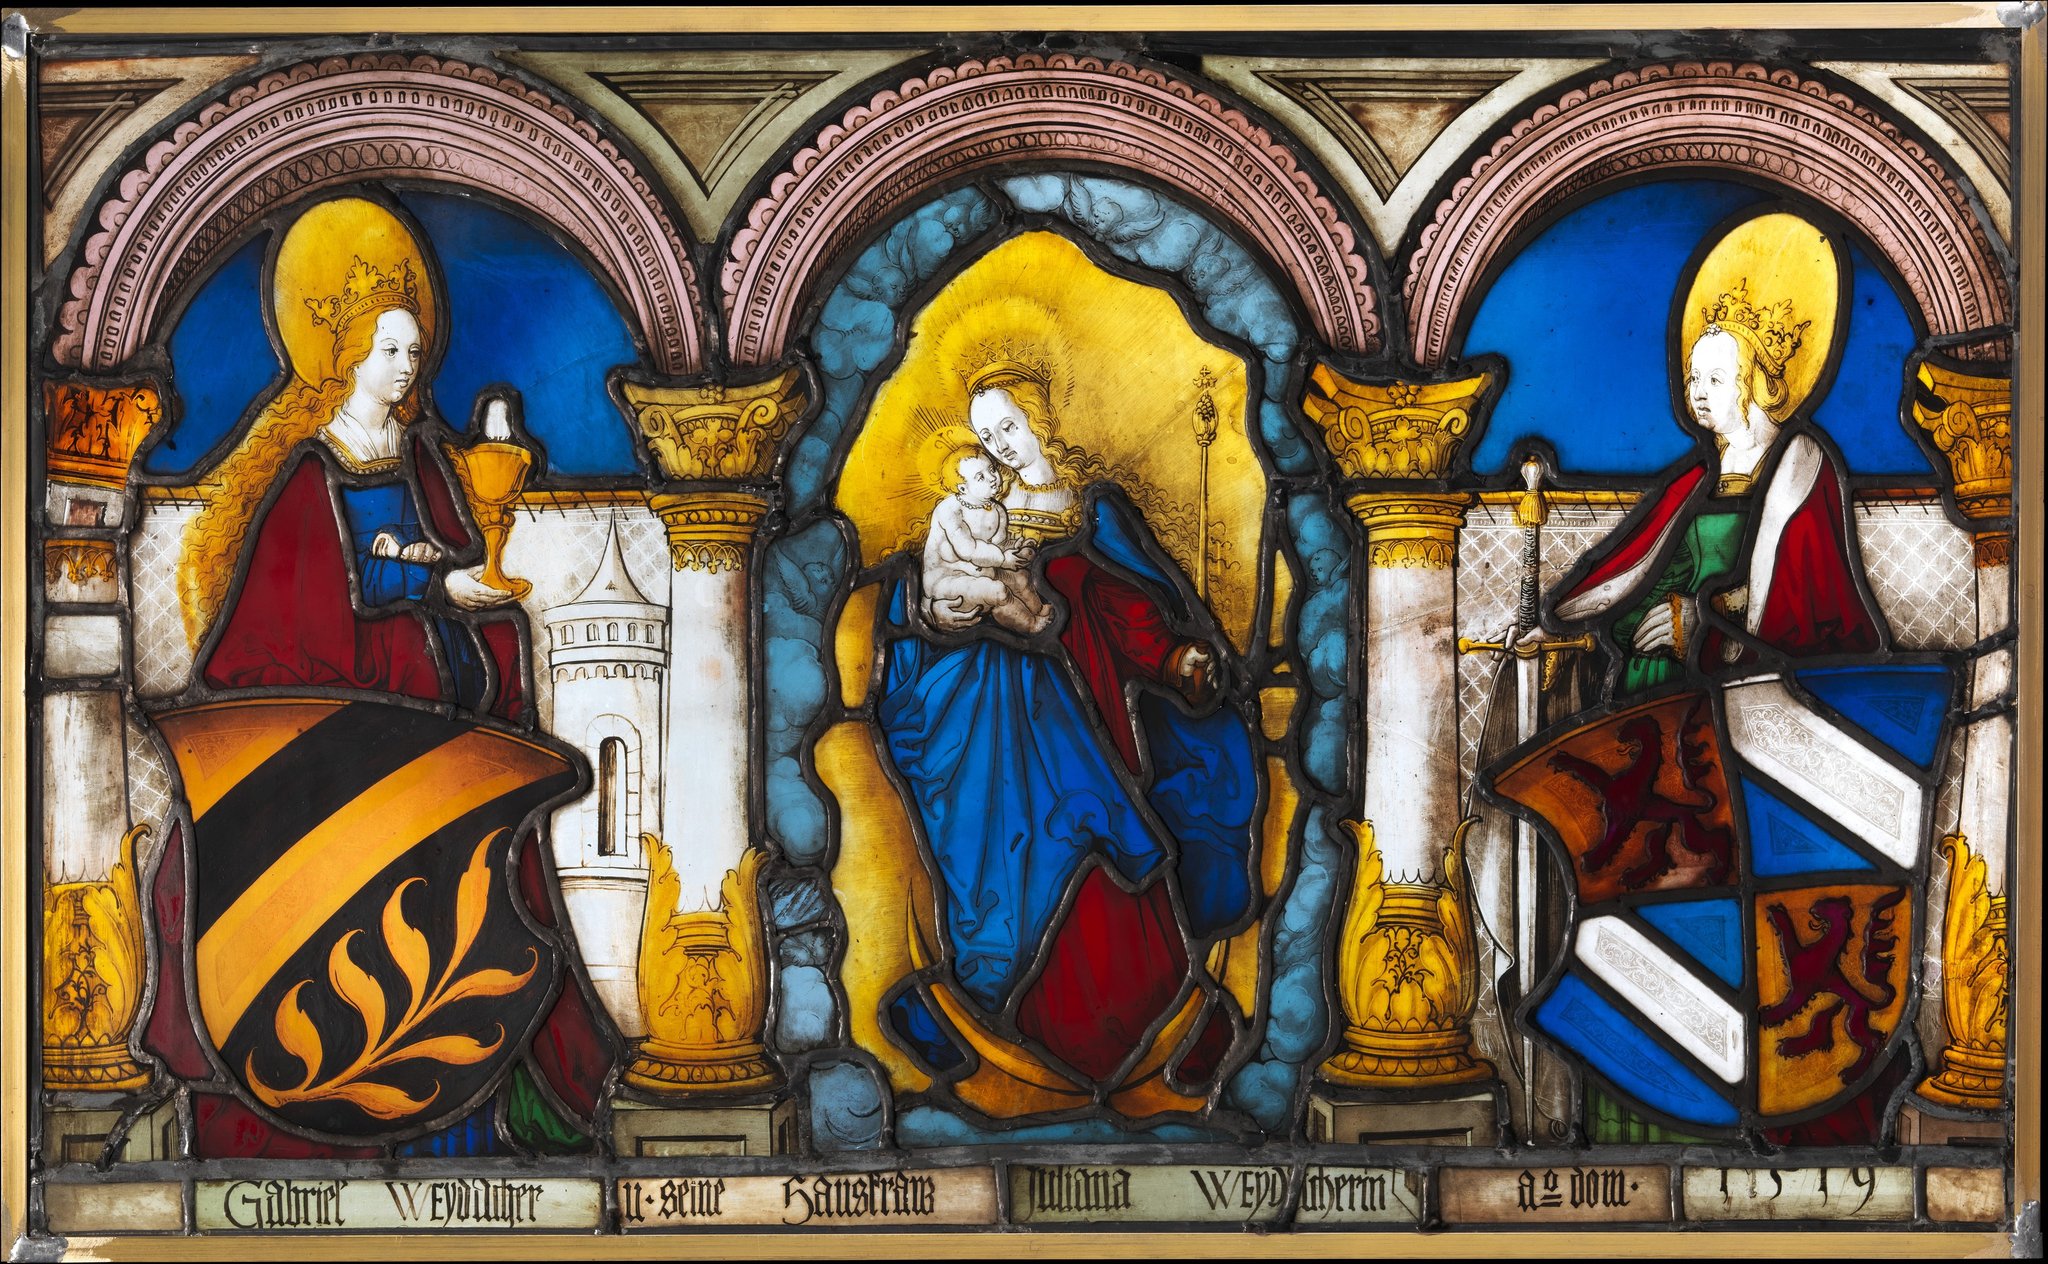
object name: panel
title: Marriage Panel of Gabriel Weydacher and his wife Juliana Wemis with the Virgin and Child and Saints Barbara and Catherine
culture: german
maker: leonhard beck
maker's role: artist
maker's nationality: german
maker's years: 1480-1542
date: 1519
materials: glass, metal, paint, pigment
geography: germany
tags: women,madonna and child,saint catherine,saints